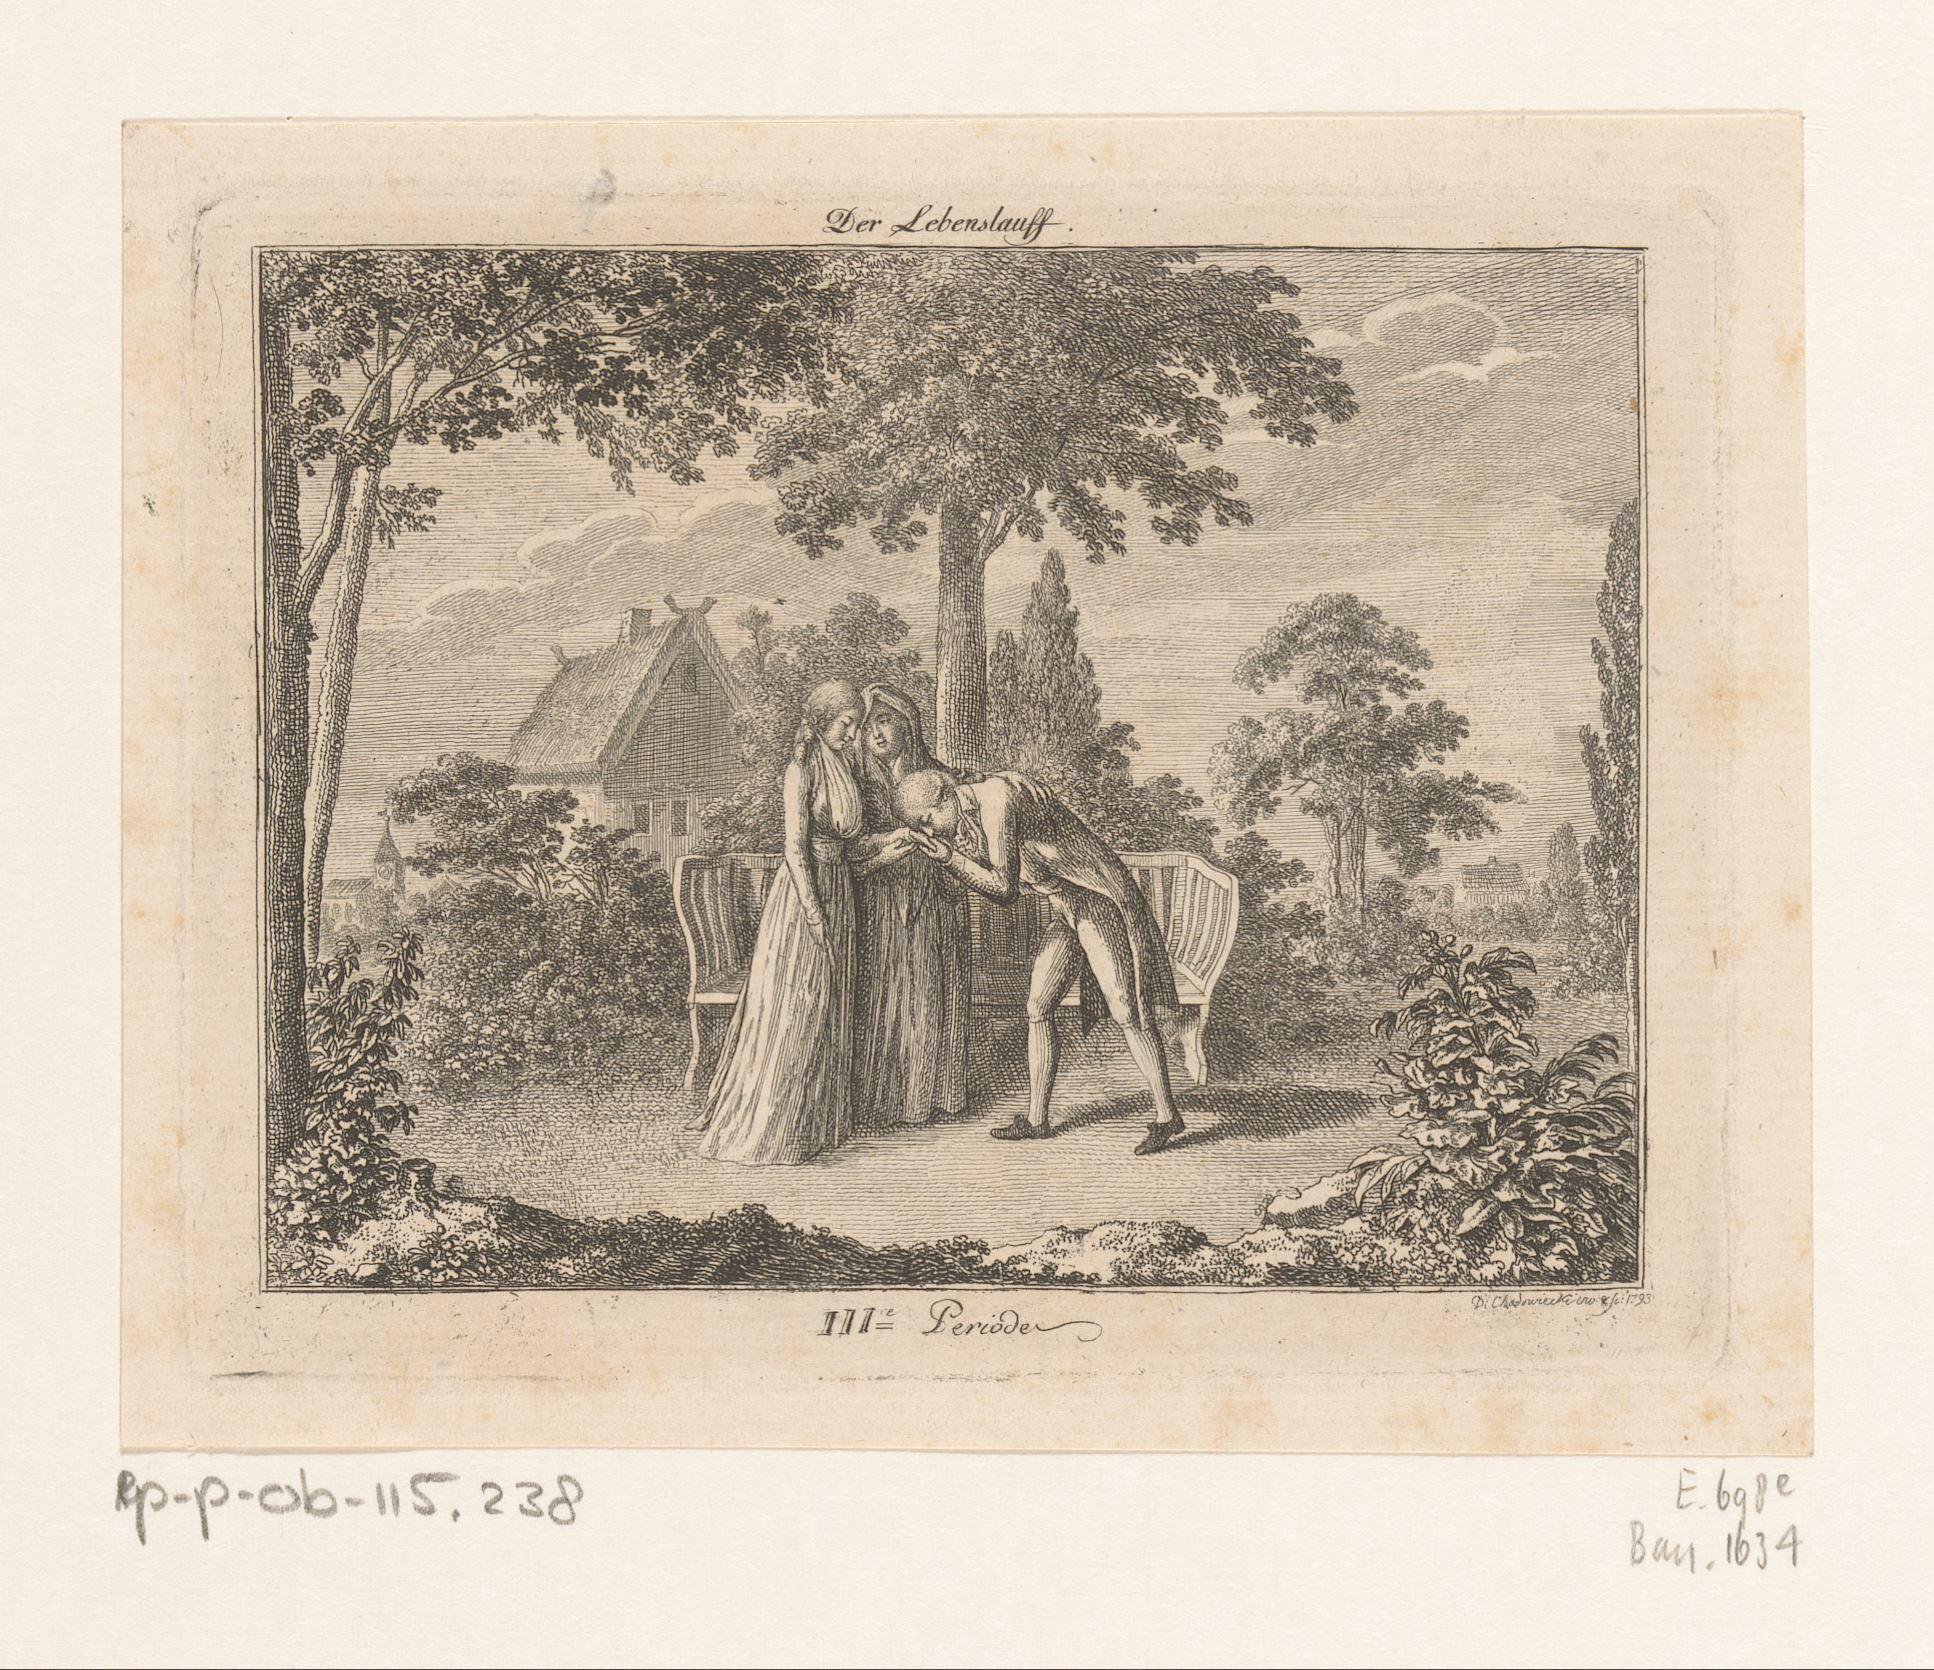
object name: print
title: Jongeman kust de hand van zijn bruid als derde periode van de levensloop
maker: daniel nikolaus chodowiecki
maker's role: draughtsman, print maker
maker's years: 1726-1801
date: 1793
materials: paper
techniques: etching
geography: berlin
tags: bench, child, farm or solitary house in landscape, the life of man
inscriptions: collector's mark: Lugt 2228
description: Onderdeel van een serie van acht prenten over de levensloop van de mens.